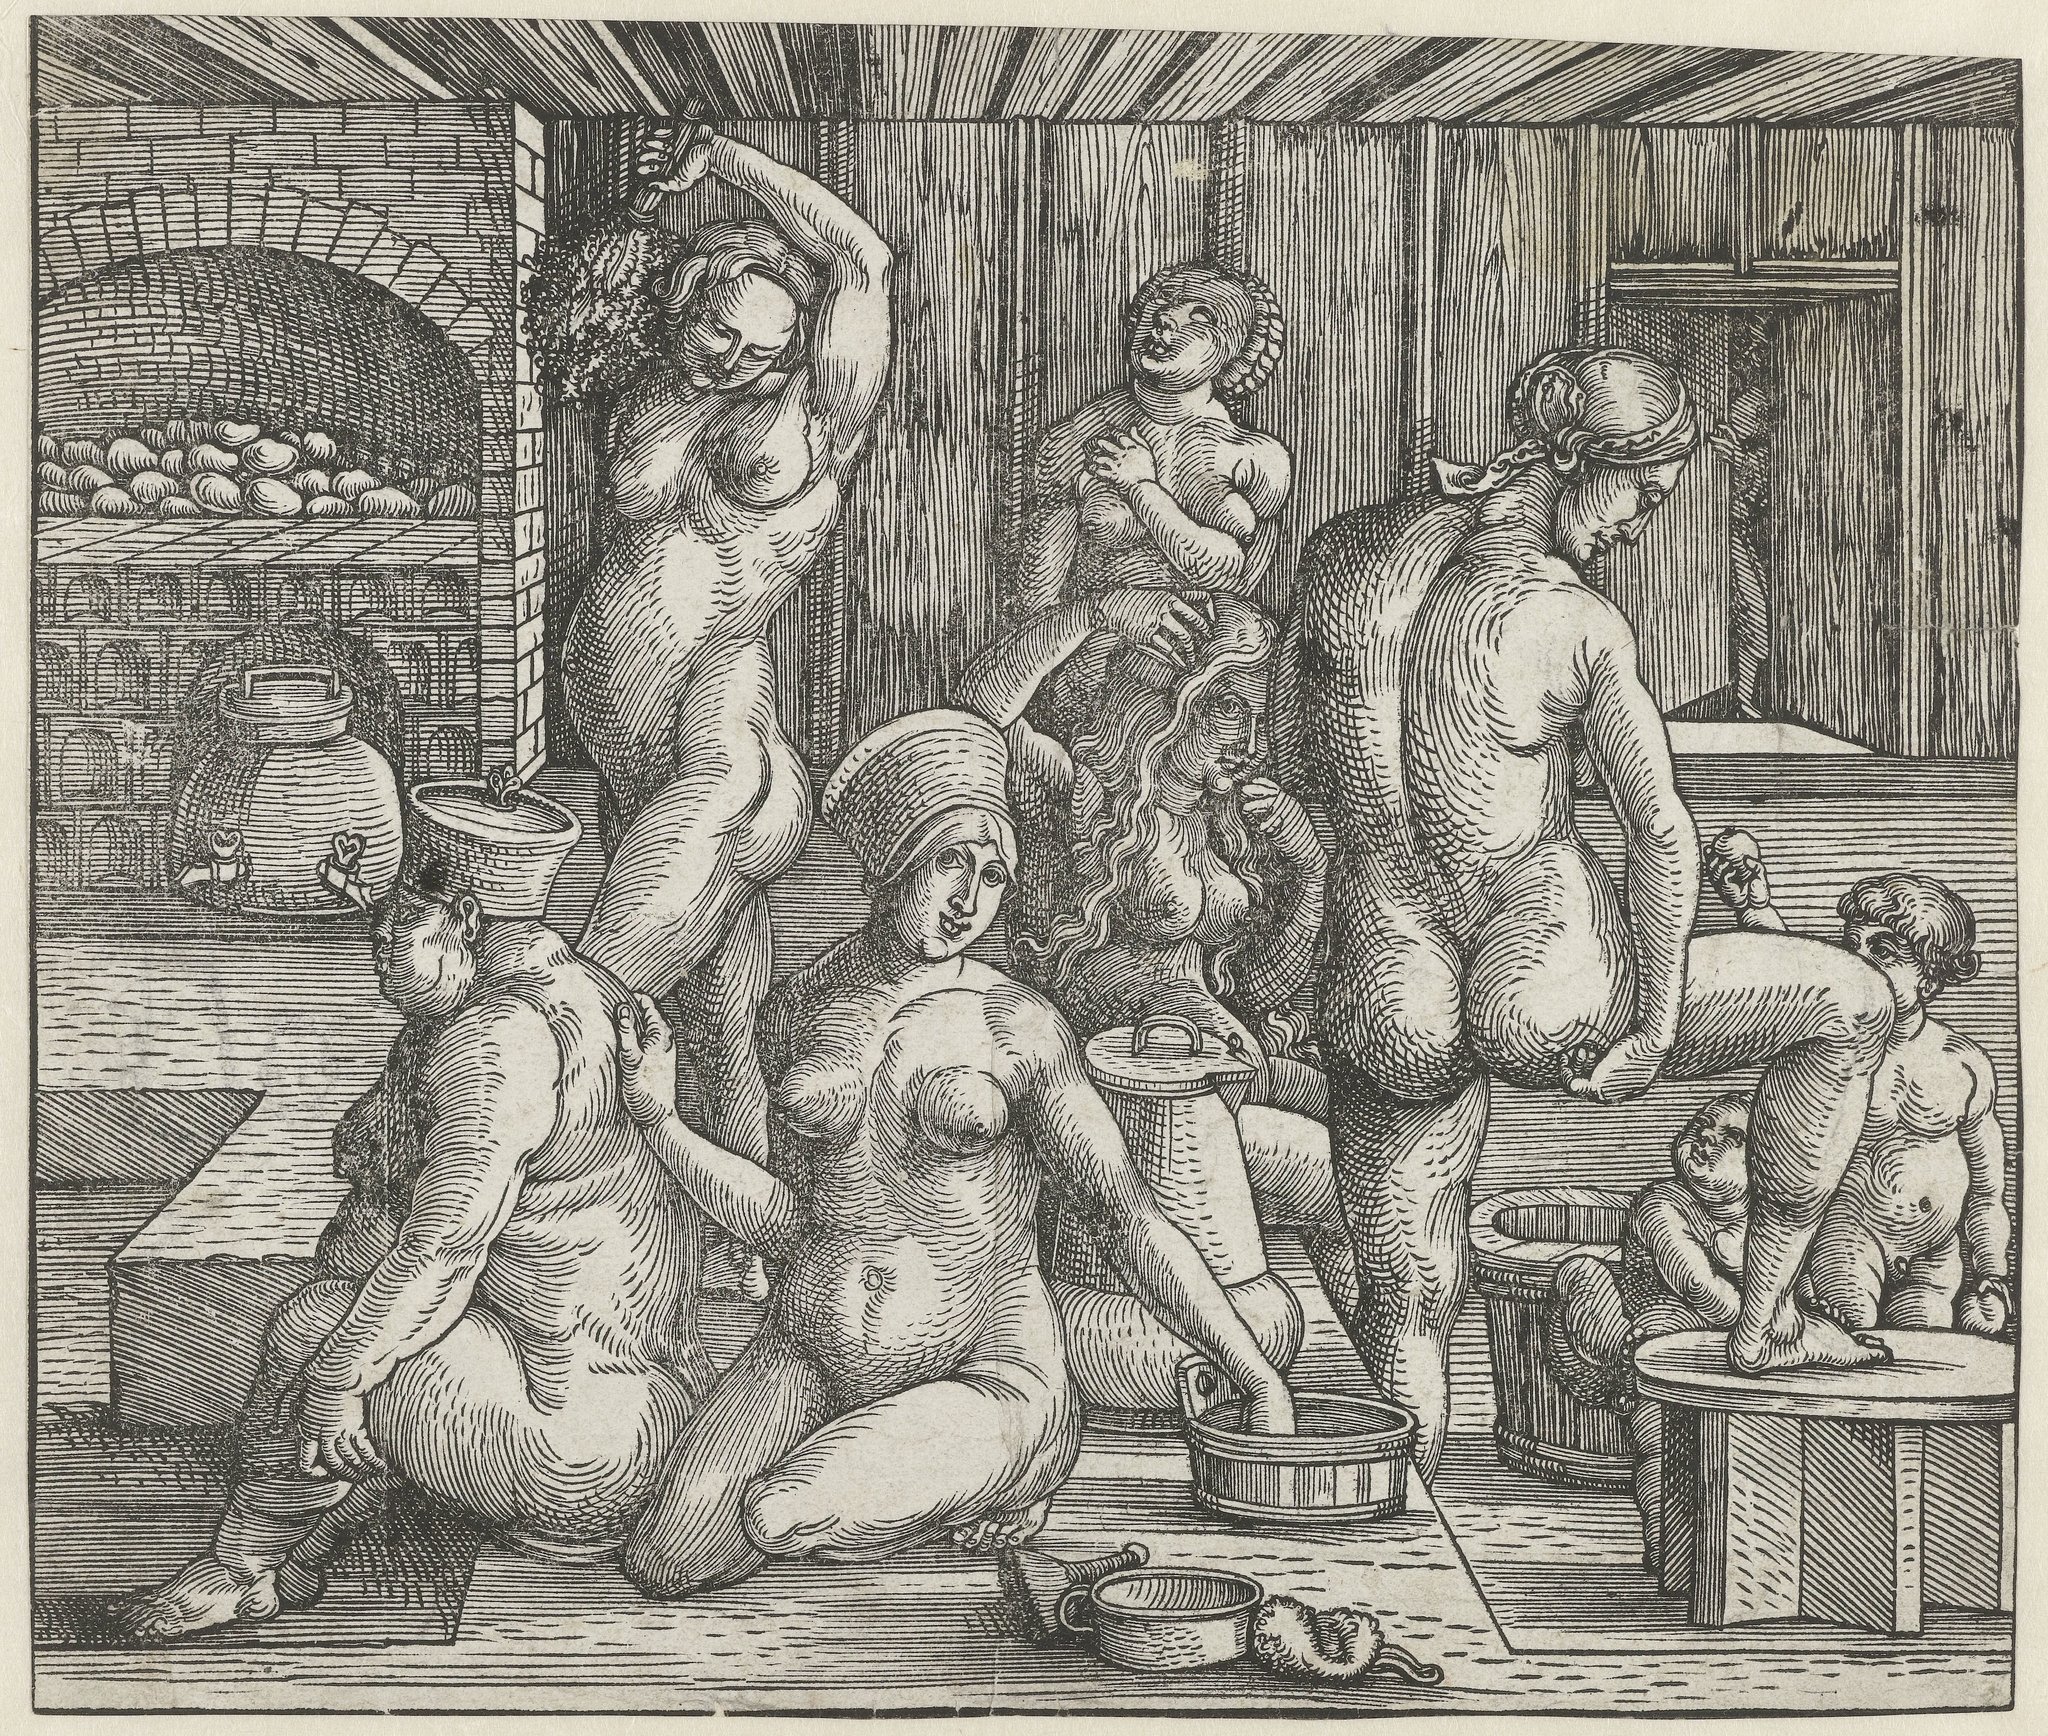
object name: print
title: Het vrouwenbad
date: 1496-1501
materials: paper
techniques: woodcut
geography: nuremberg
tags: taking a bath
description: Zes naakte vrouwen en twee kleine kinderen zijn in een badkamer of sauna in de weer met water en zeep, sponzen en borstels etc.